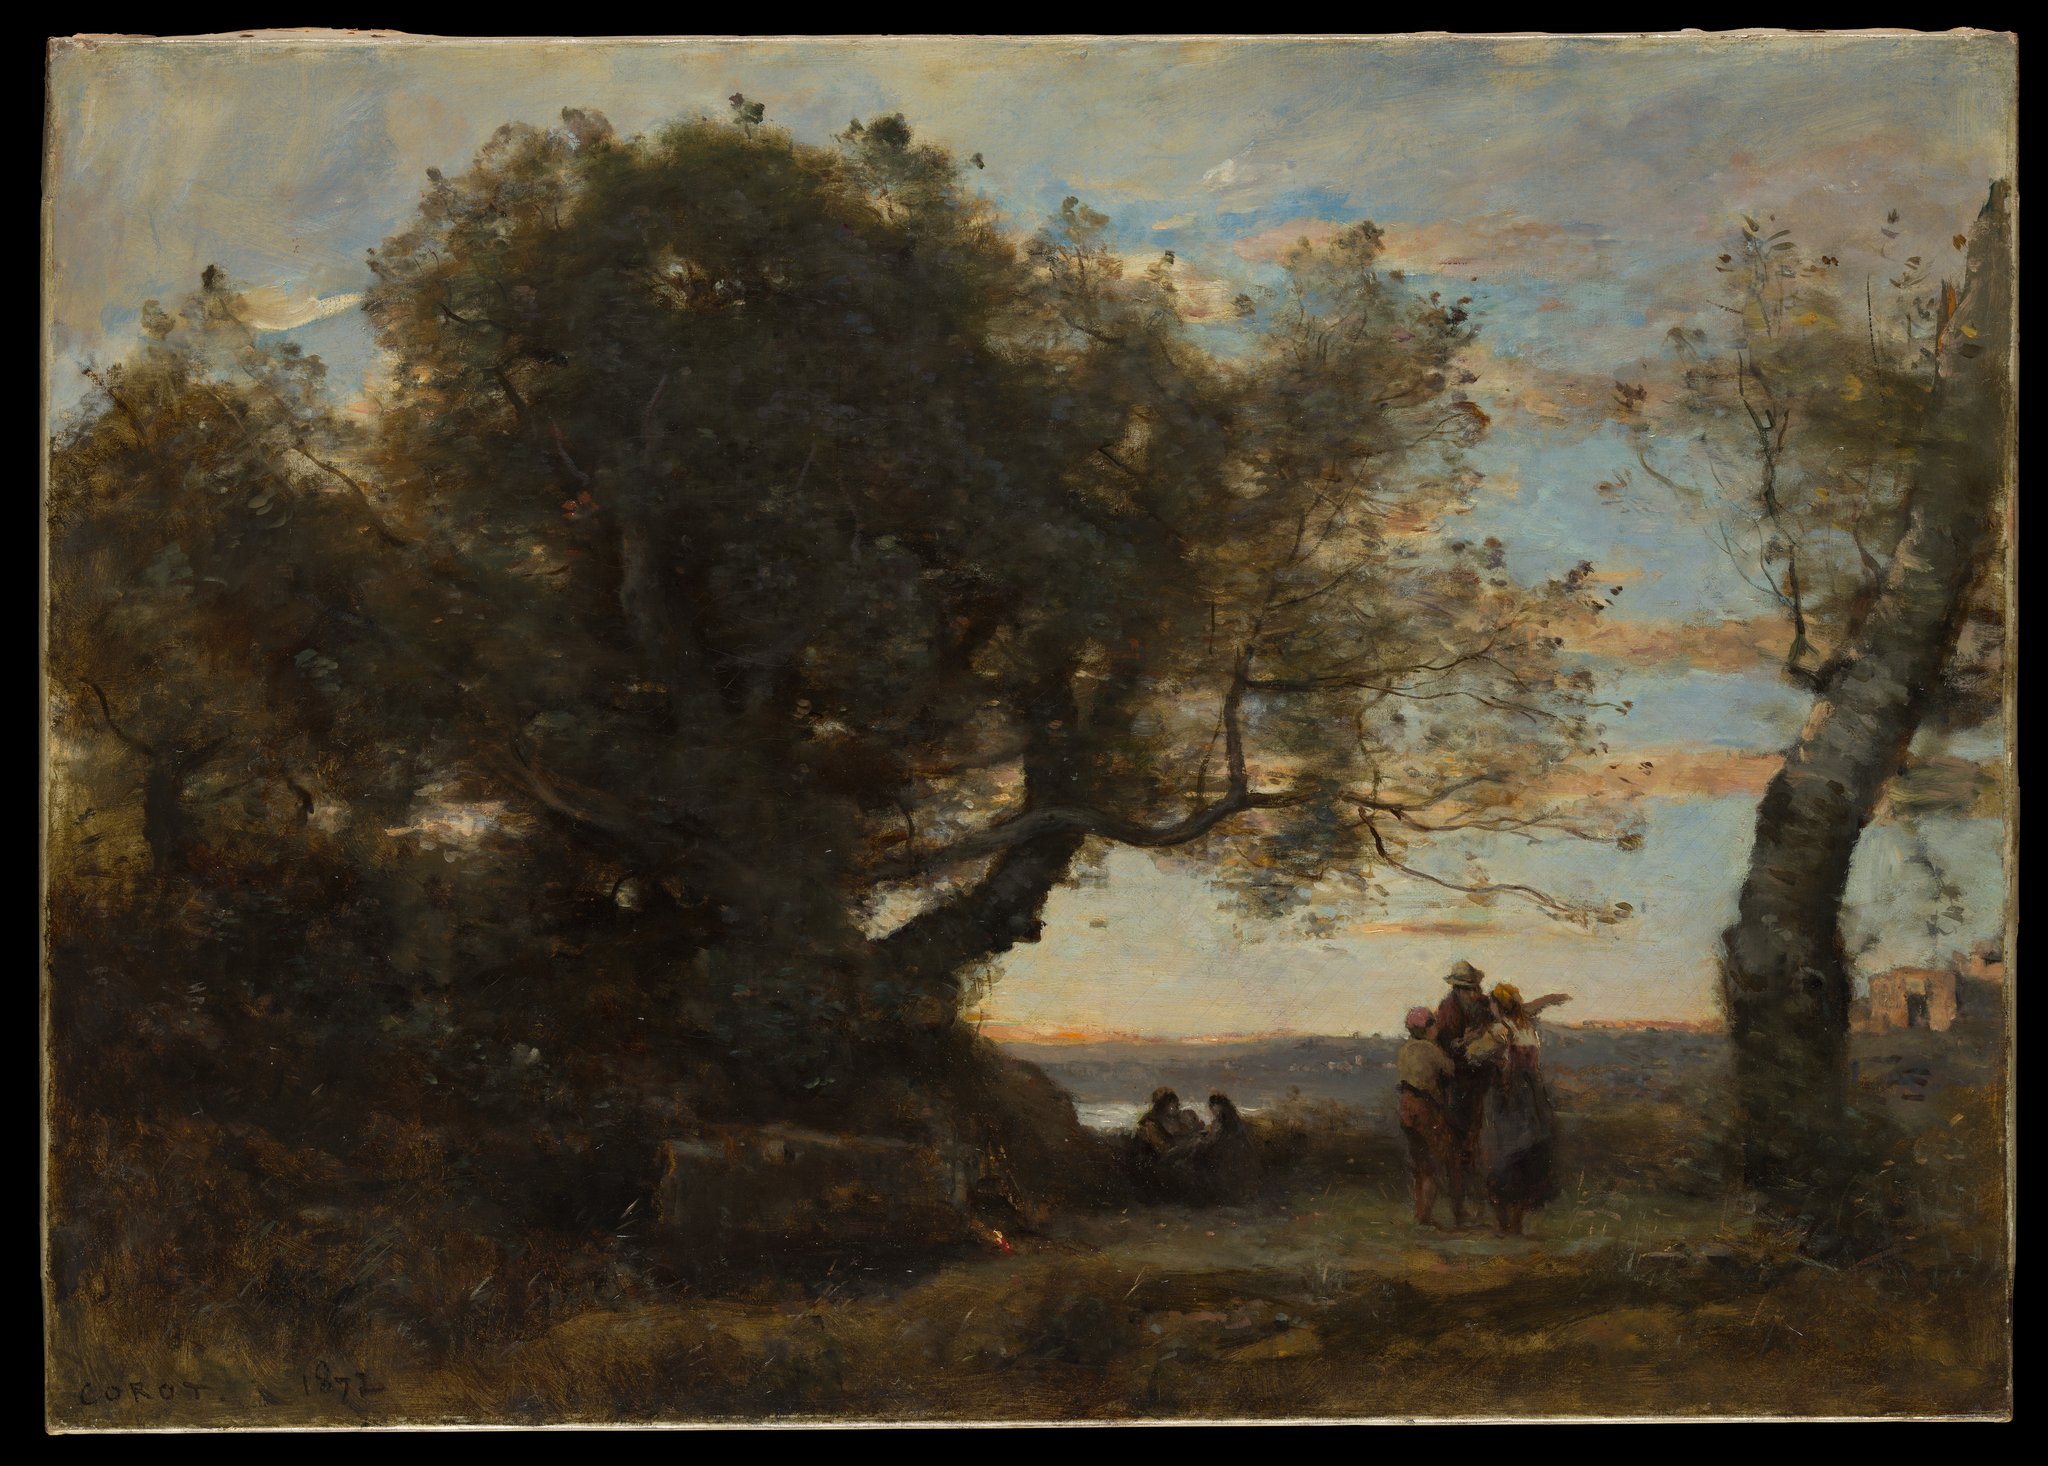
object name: painting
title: Landscape with Figures (Les Bohémiens)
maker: jean-baptiste-camille corot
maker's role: artist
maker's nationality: french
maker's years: 1796-1875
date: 1872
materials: canvas, oil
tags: forests,landscapes